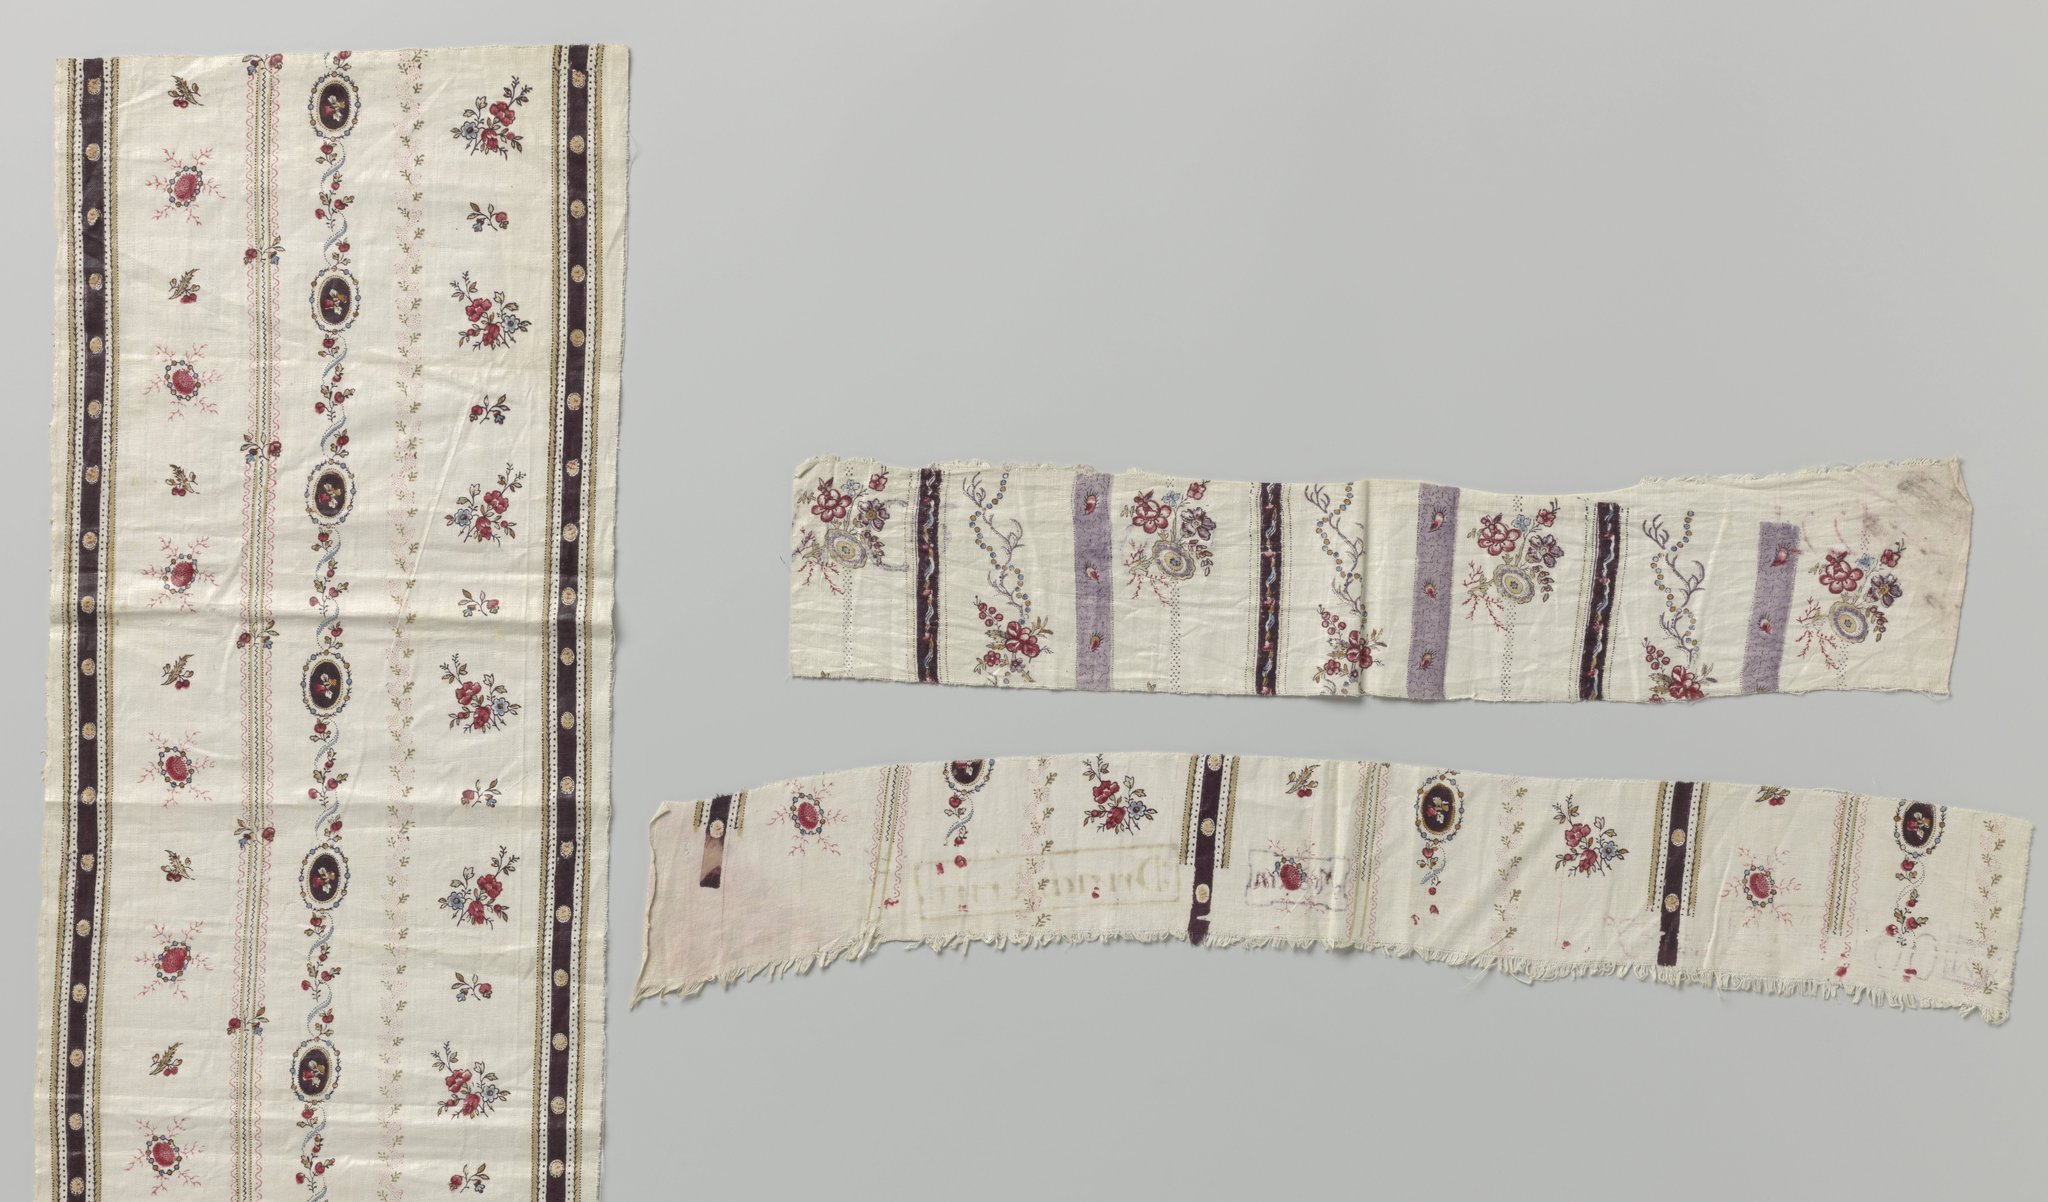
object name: fragment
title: Fragmenten sits met streeppatroon op witte grond met auberginekleurige ovalen, gevat in verticale slingers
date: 1785-1795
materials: cotton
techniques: printing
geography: alsace